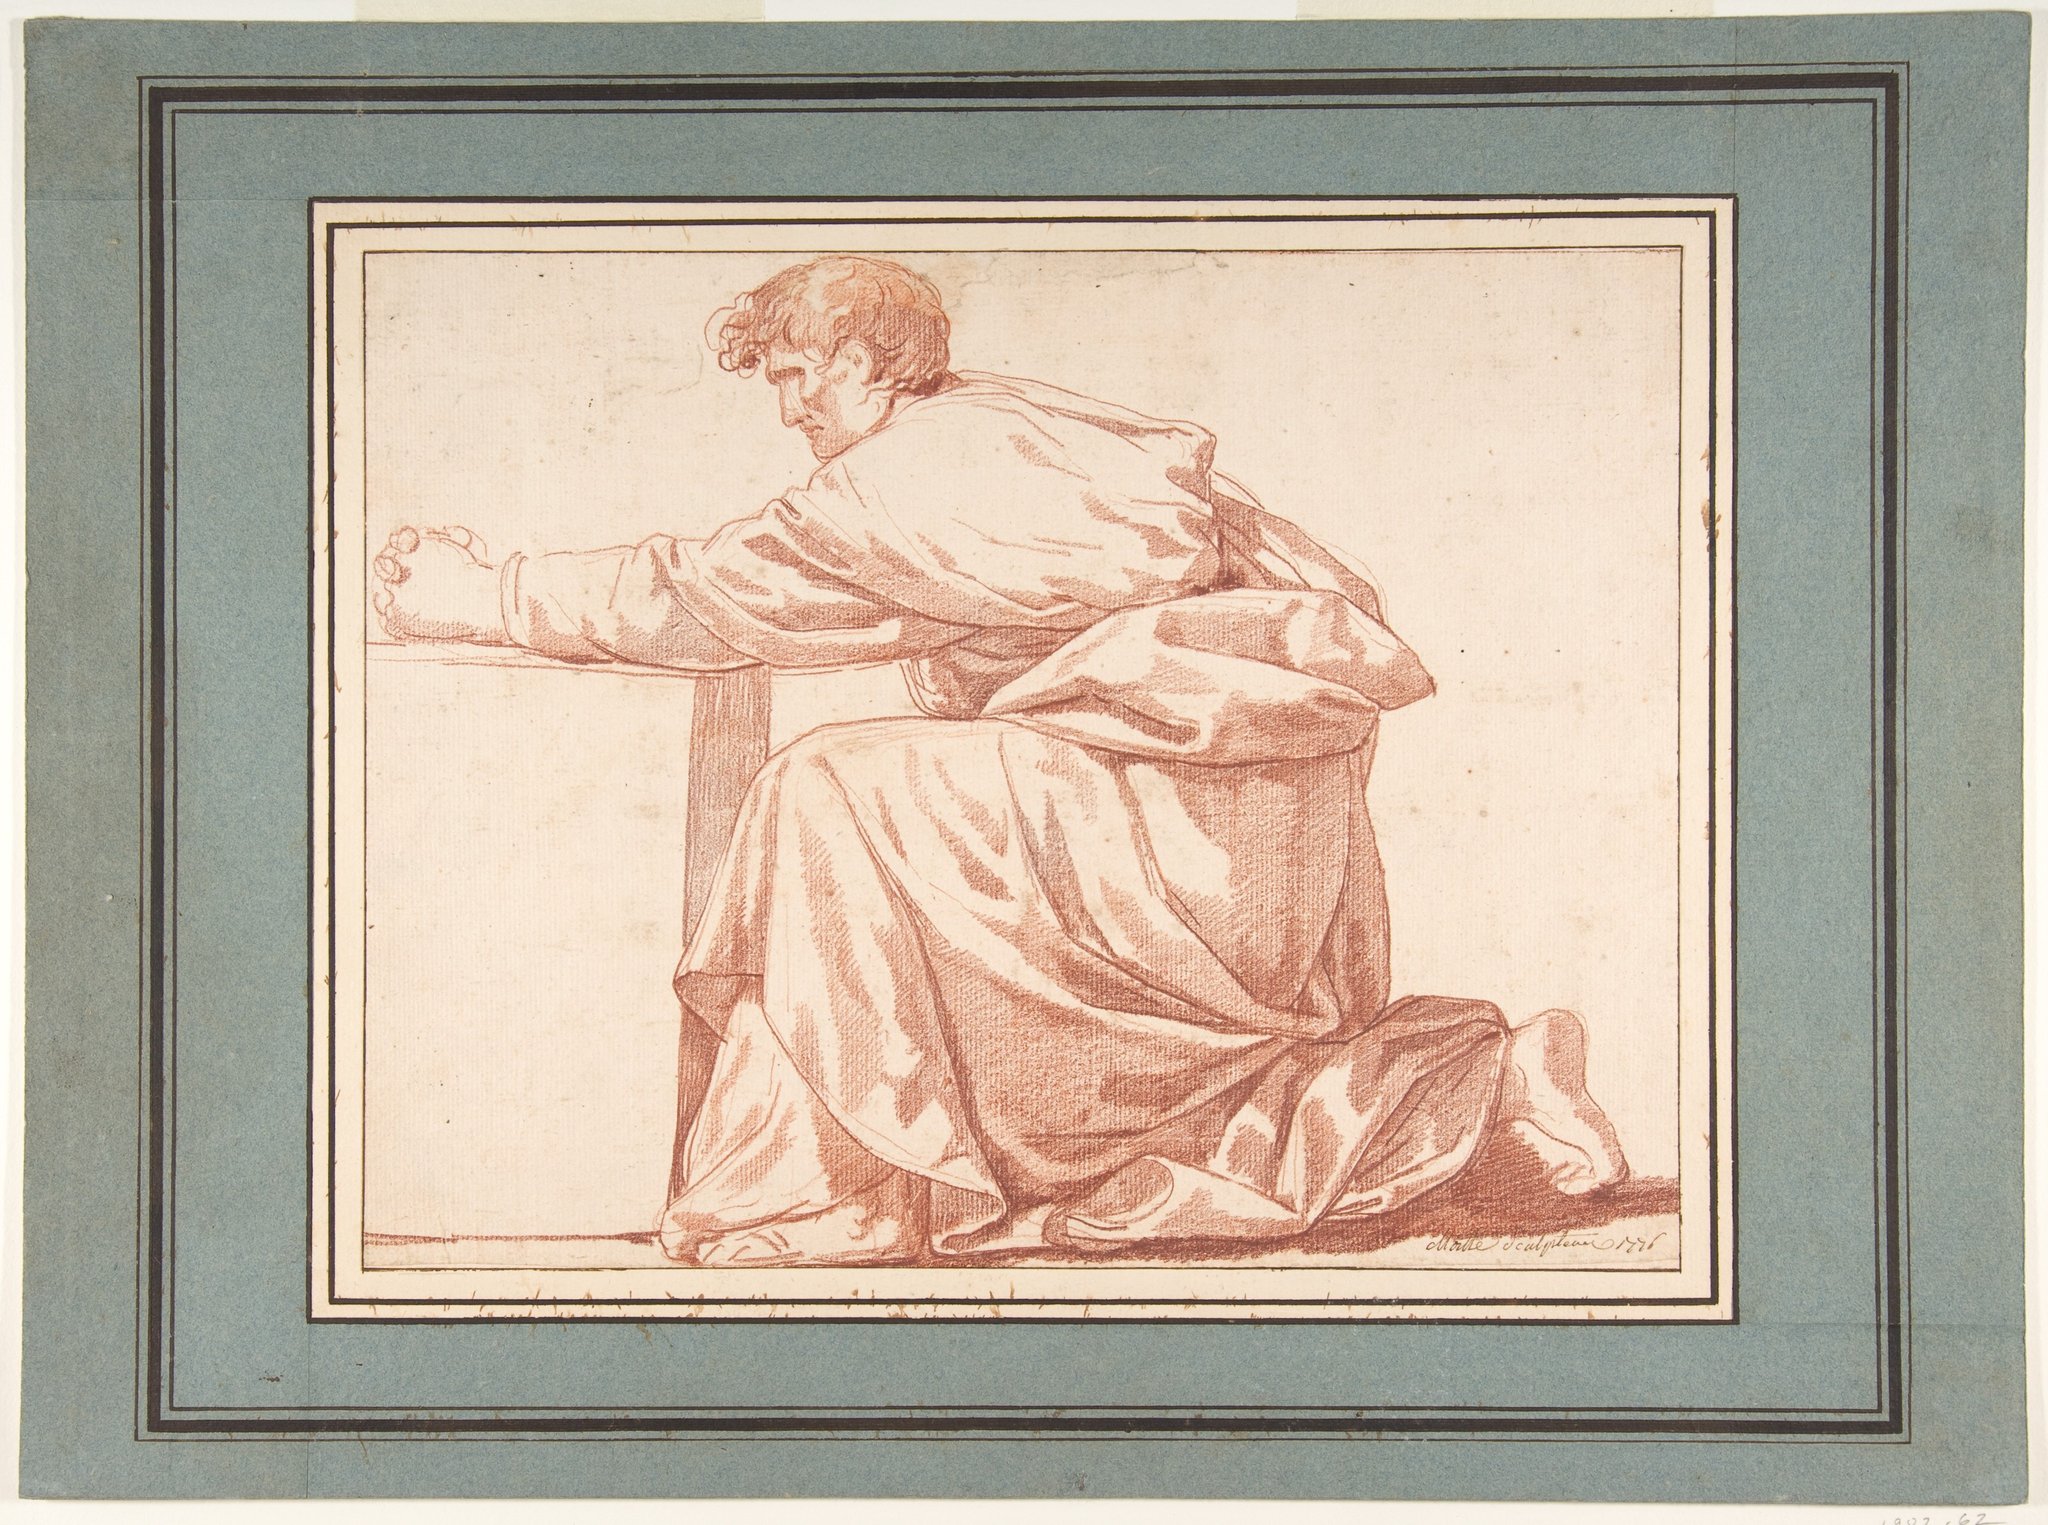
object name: drawing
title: Kneeling Draped Male Figure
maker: jean guillaume moitte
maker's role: artist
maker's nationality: french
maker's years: 1746-1810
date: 1776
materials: chalk, ink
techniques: pen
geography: france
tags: men